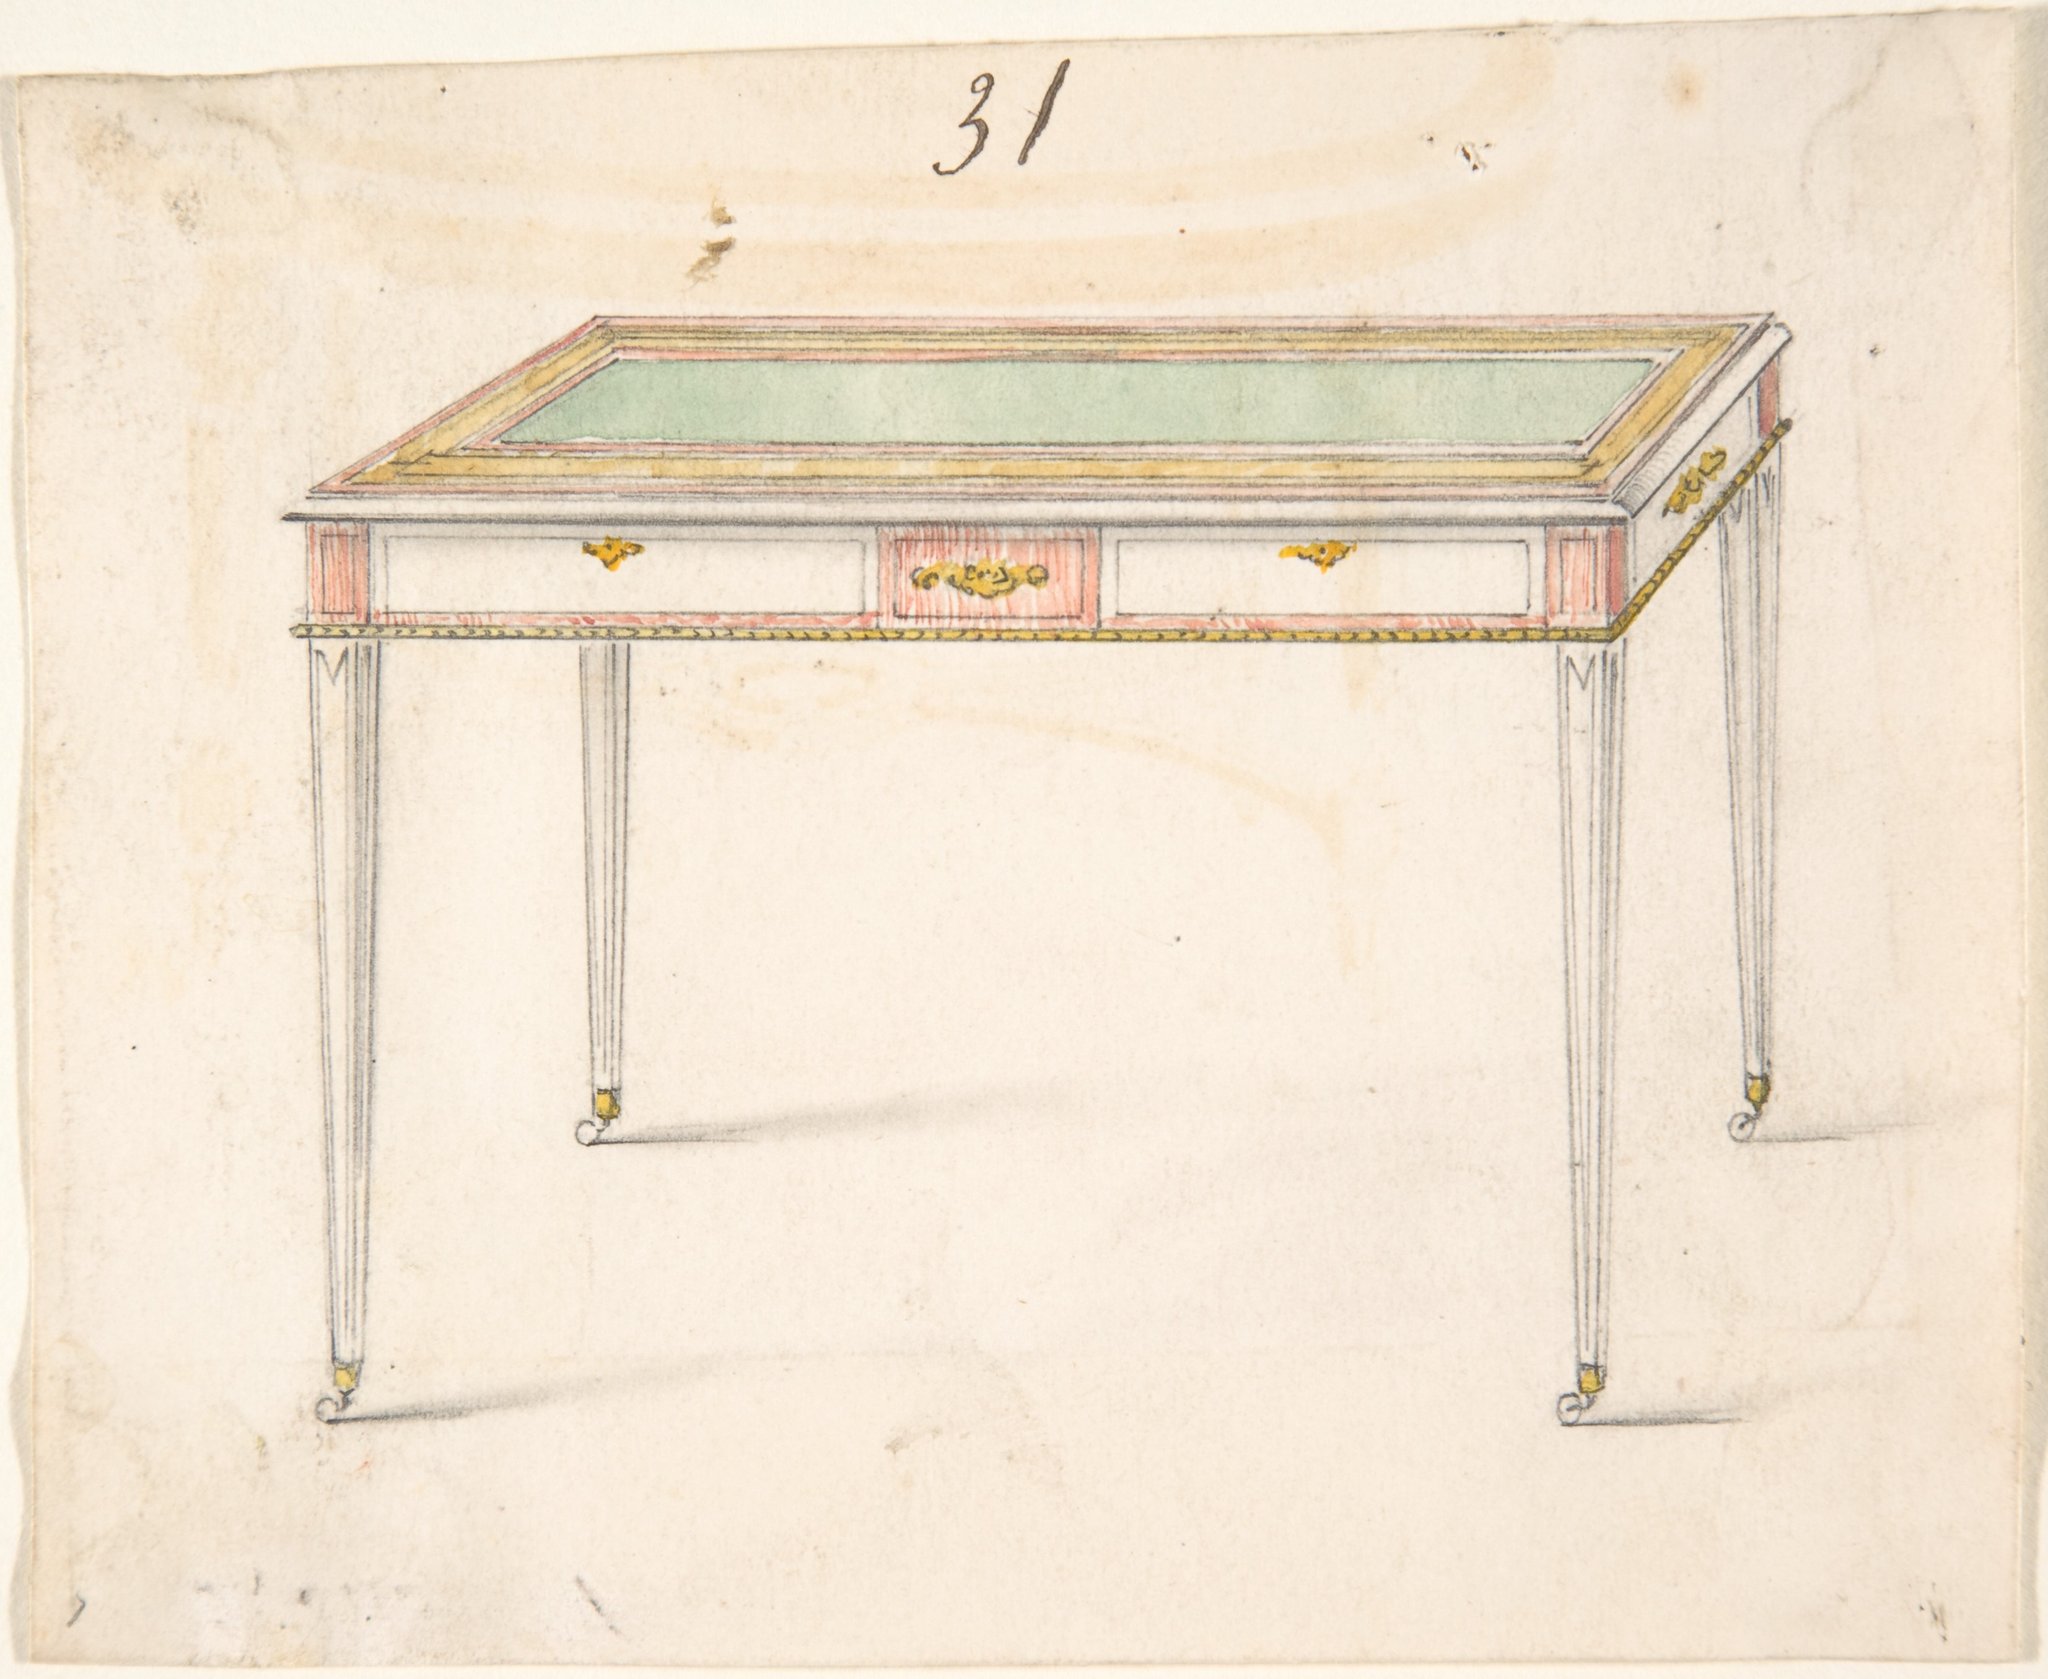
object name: drawing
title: Table Design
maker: anonymous, british, 19th century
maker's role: artist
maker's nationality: british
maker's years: 1800-1900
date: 1801-1900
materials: ink, watercolor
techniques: pen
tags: tables